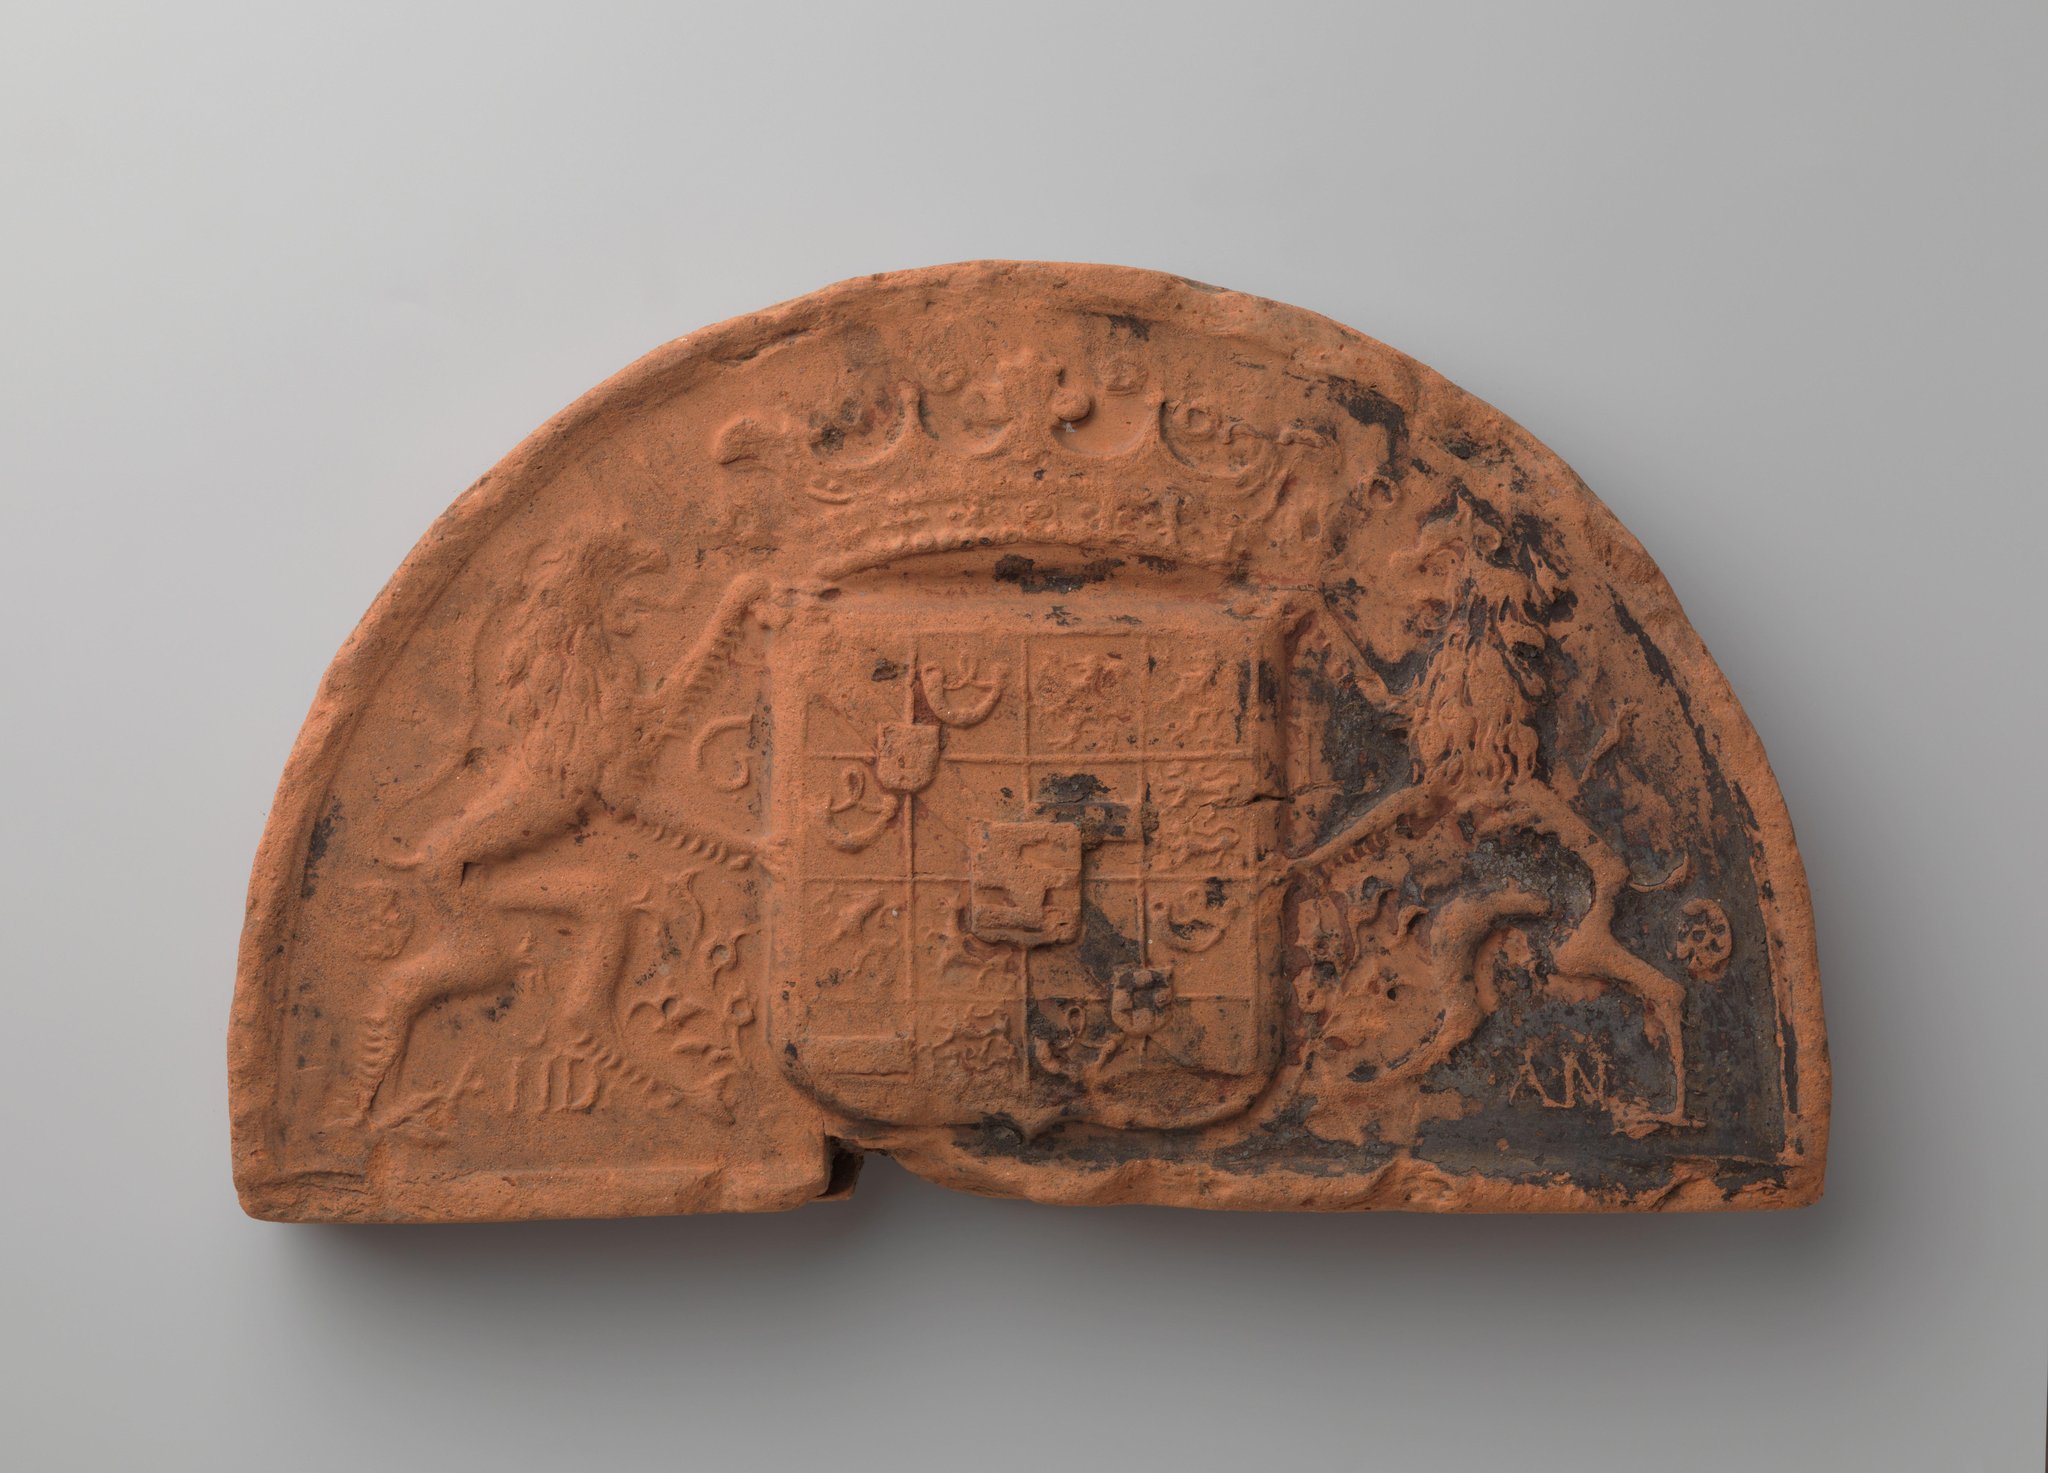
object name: haarddeksteen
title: Halfronde haarddeksteen met het wapenschild van Maurits van Nassau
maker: Anonymous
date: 1575-1600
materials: earthenware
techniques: printing, firing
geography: southern netherlands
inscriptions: inscription: ‘AND AN’, inscription: ‘GM’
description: Halfronde haardsteen van gebakken aardewerk. Versierd met het gekroonde wapenschild van Maurits van Nassau, vastgehouden door twee leeuwen. Naast het schild de letters G(raaf) en M(aurits). Onder de leeuwen aan de ene zijde: AND. en aan de andere zijde AN.